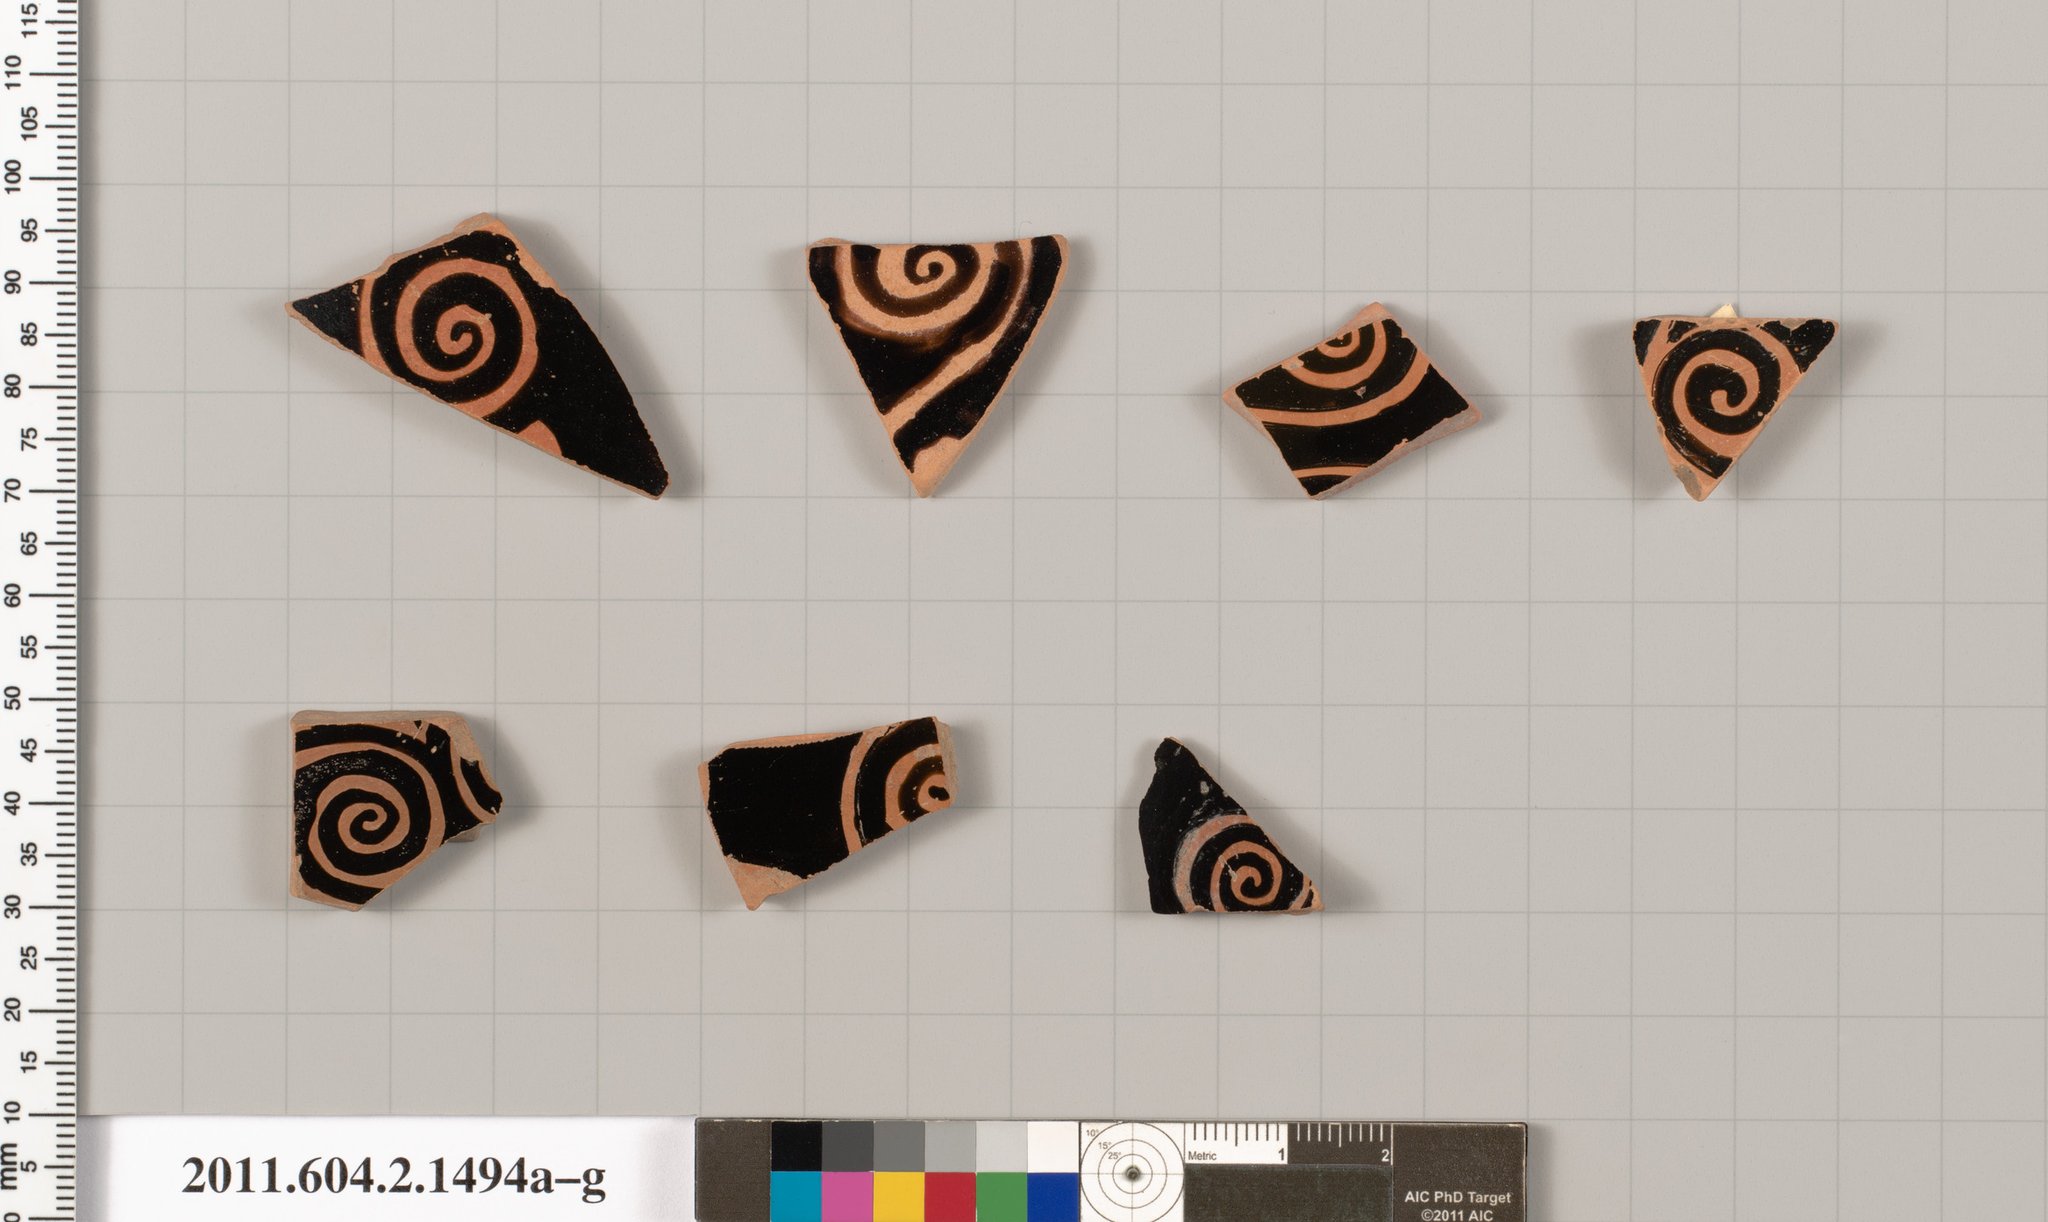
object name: skyphos fragment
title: Terracotta fragments of skyphoi (deep drinking cups)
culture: greek, attic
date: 475-425 BCE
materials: terracotta